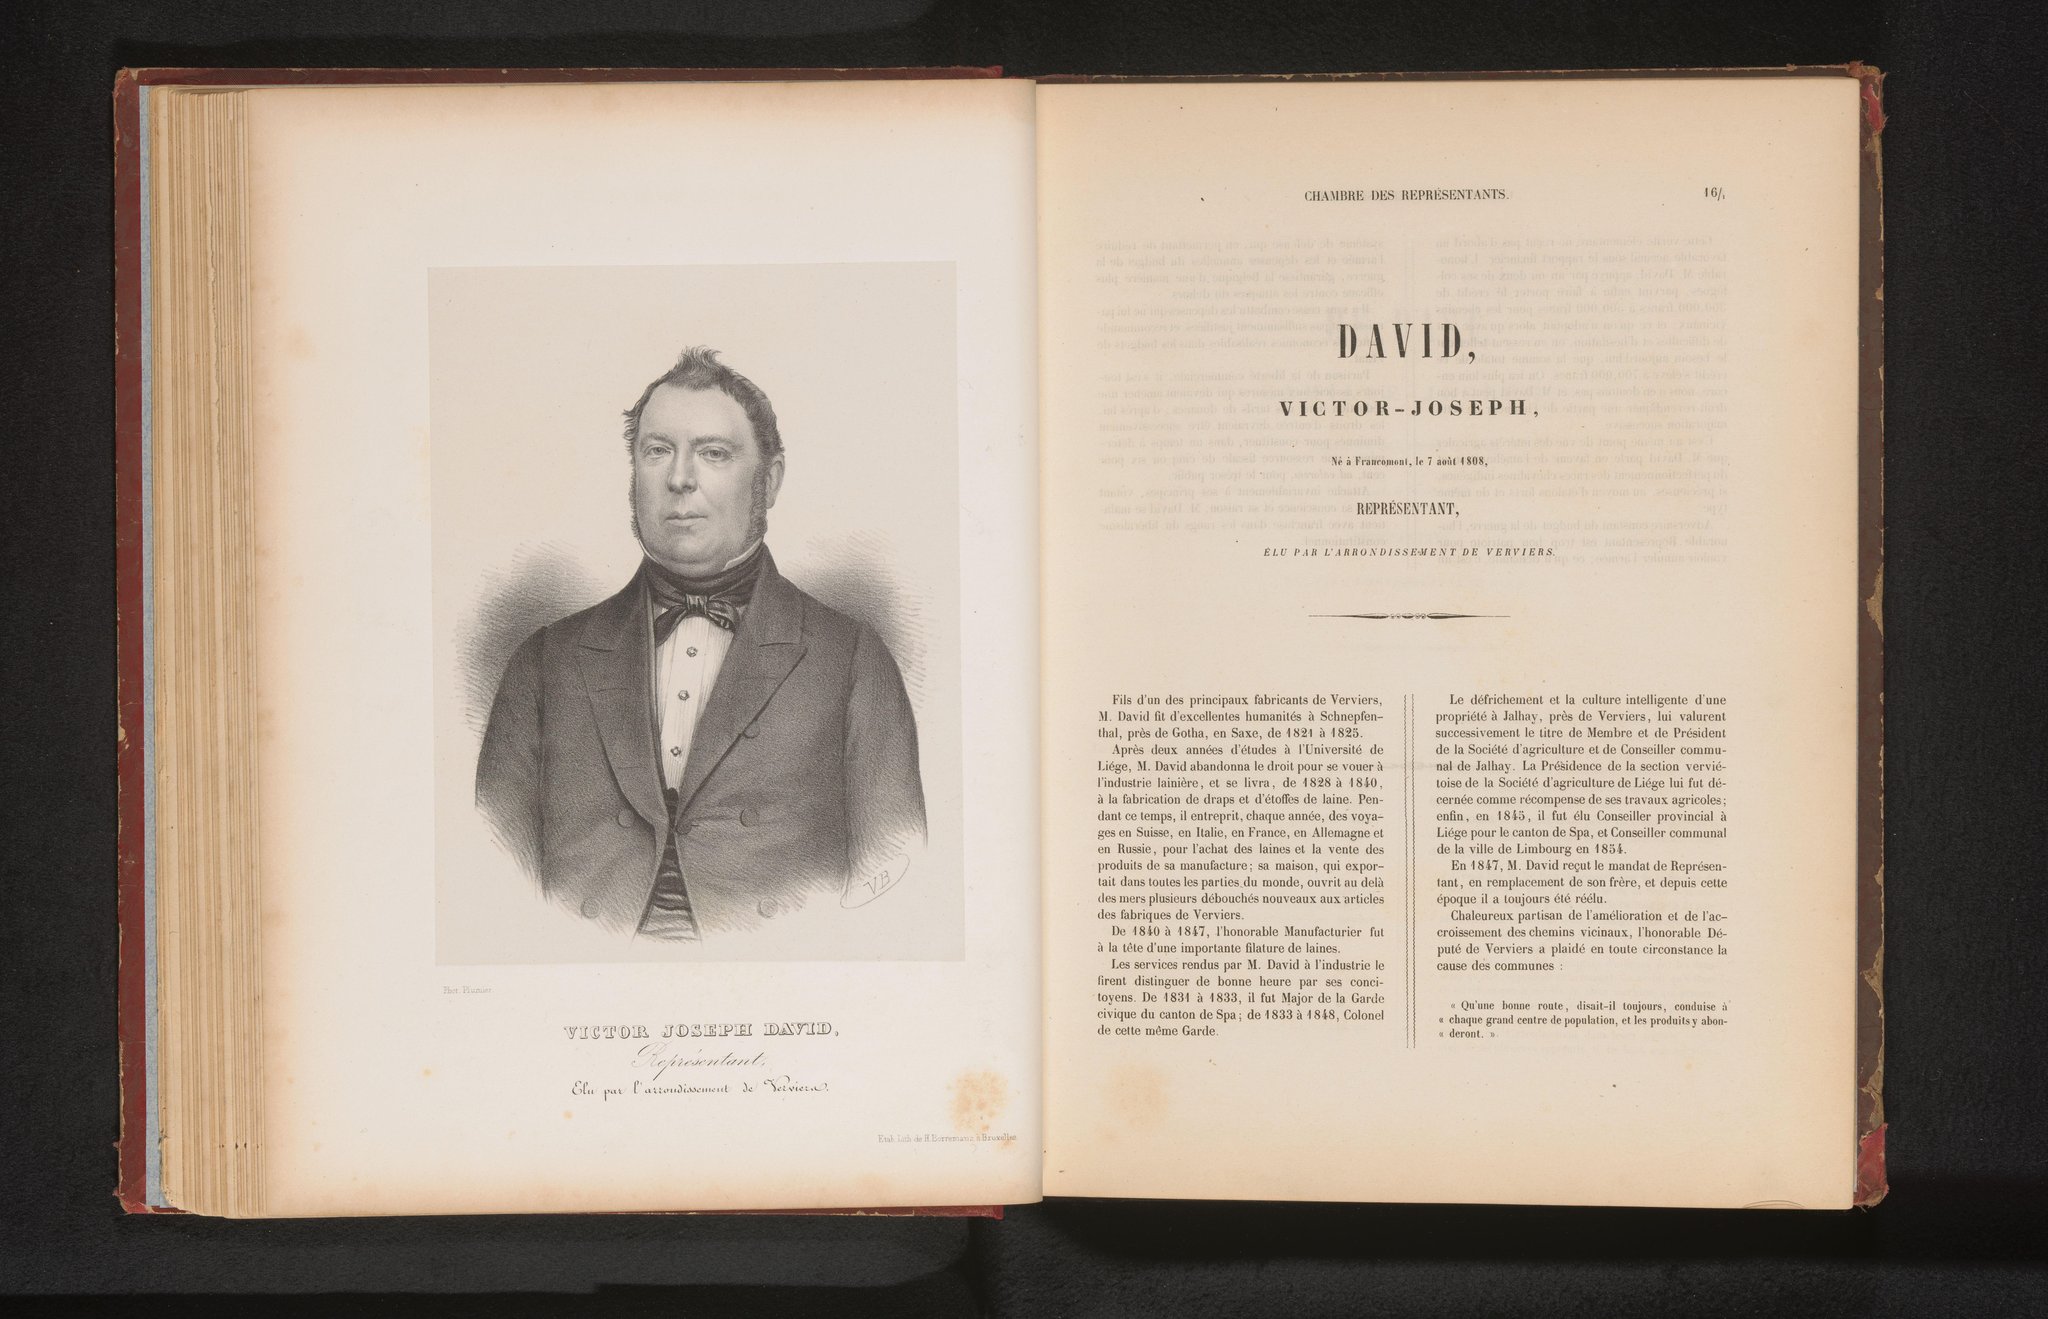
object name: print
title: Victor Joseph David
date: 1853-1858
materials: paper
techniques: lithograph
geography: brussels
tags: politician, historical persons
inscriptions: inscription: ‘Représentant,/ Elu par l'arrondissement de Verviers.’